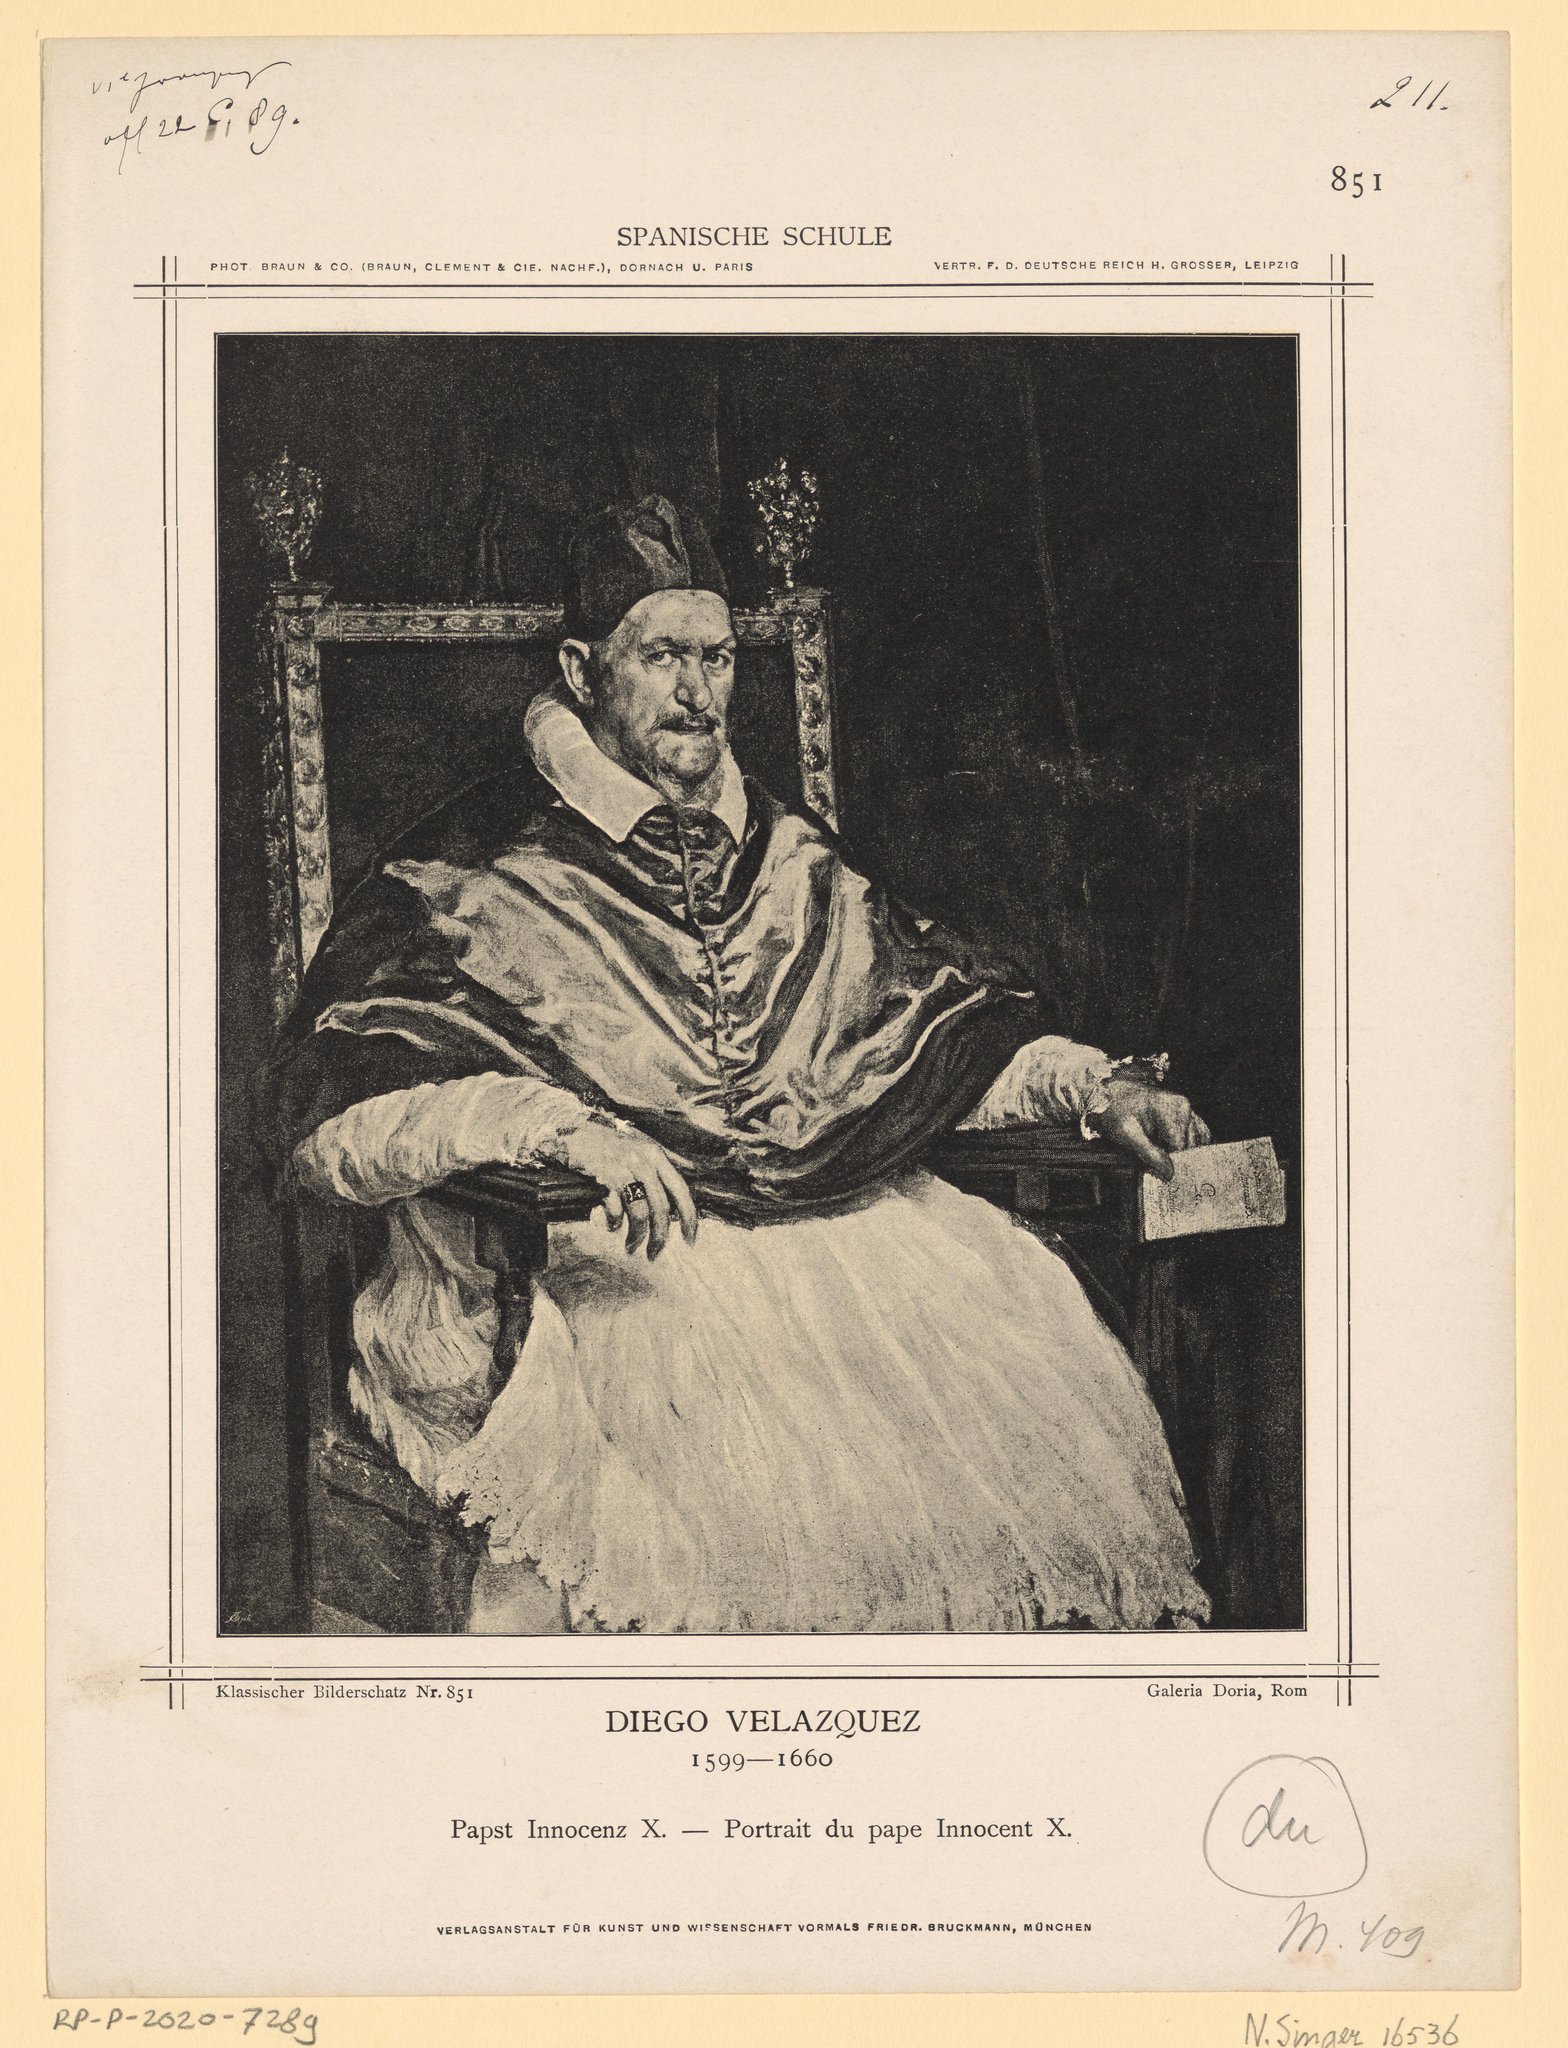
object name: photomechanical print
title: Portret van paus Innocentius X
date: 1894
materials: paper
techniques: letterpress printing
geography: munich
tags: rome, innocentius x, historical persons, pope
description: Fotomechanische afdruk mogelijk uit: Reber, Franz von en Adolph Bayersdorfer. Klassischer Bilderschatz. München: Verlagsanstalt für Kunst und Wissenschaft, 1894, dl. 6.